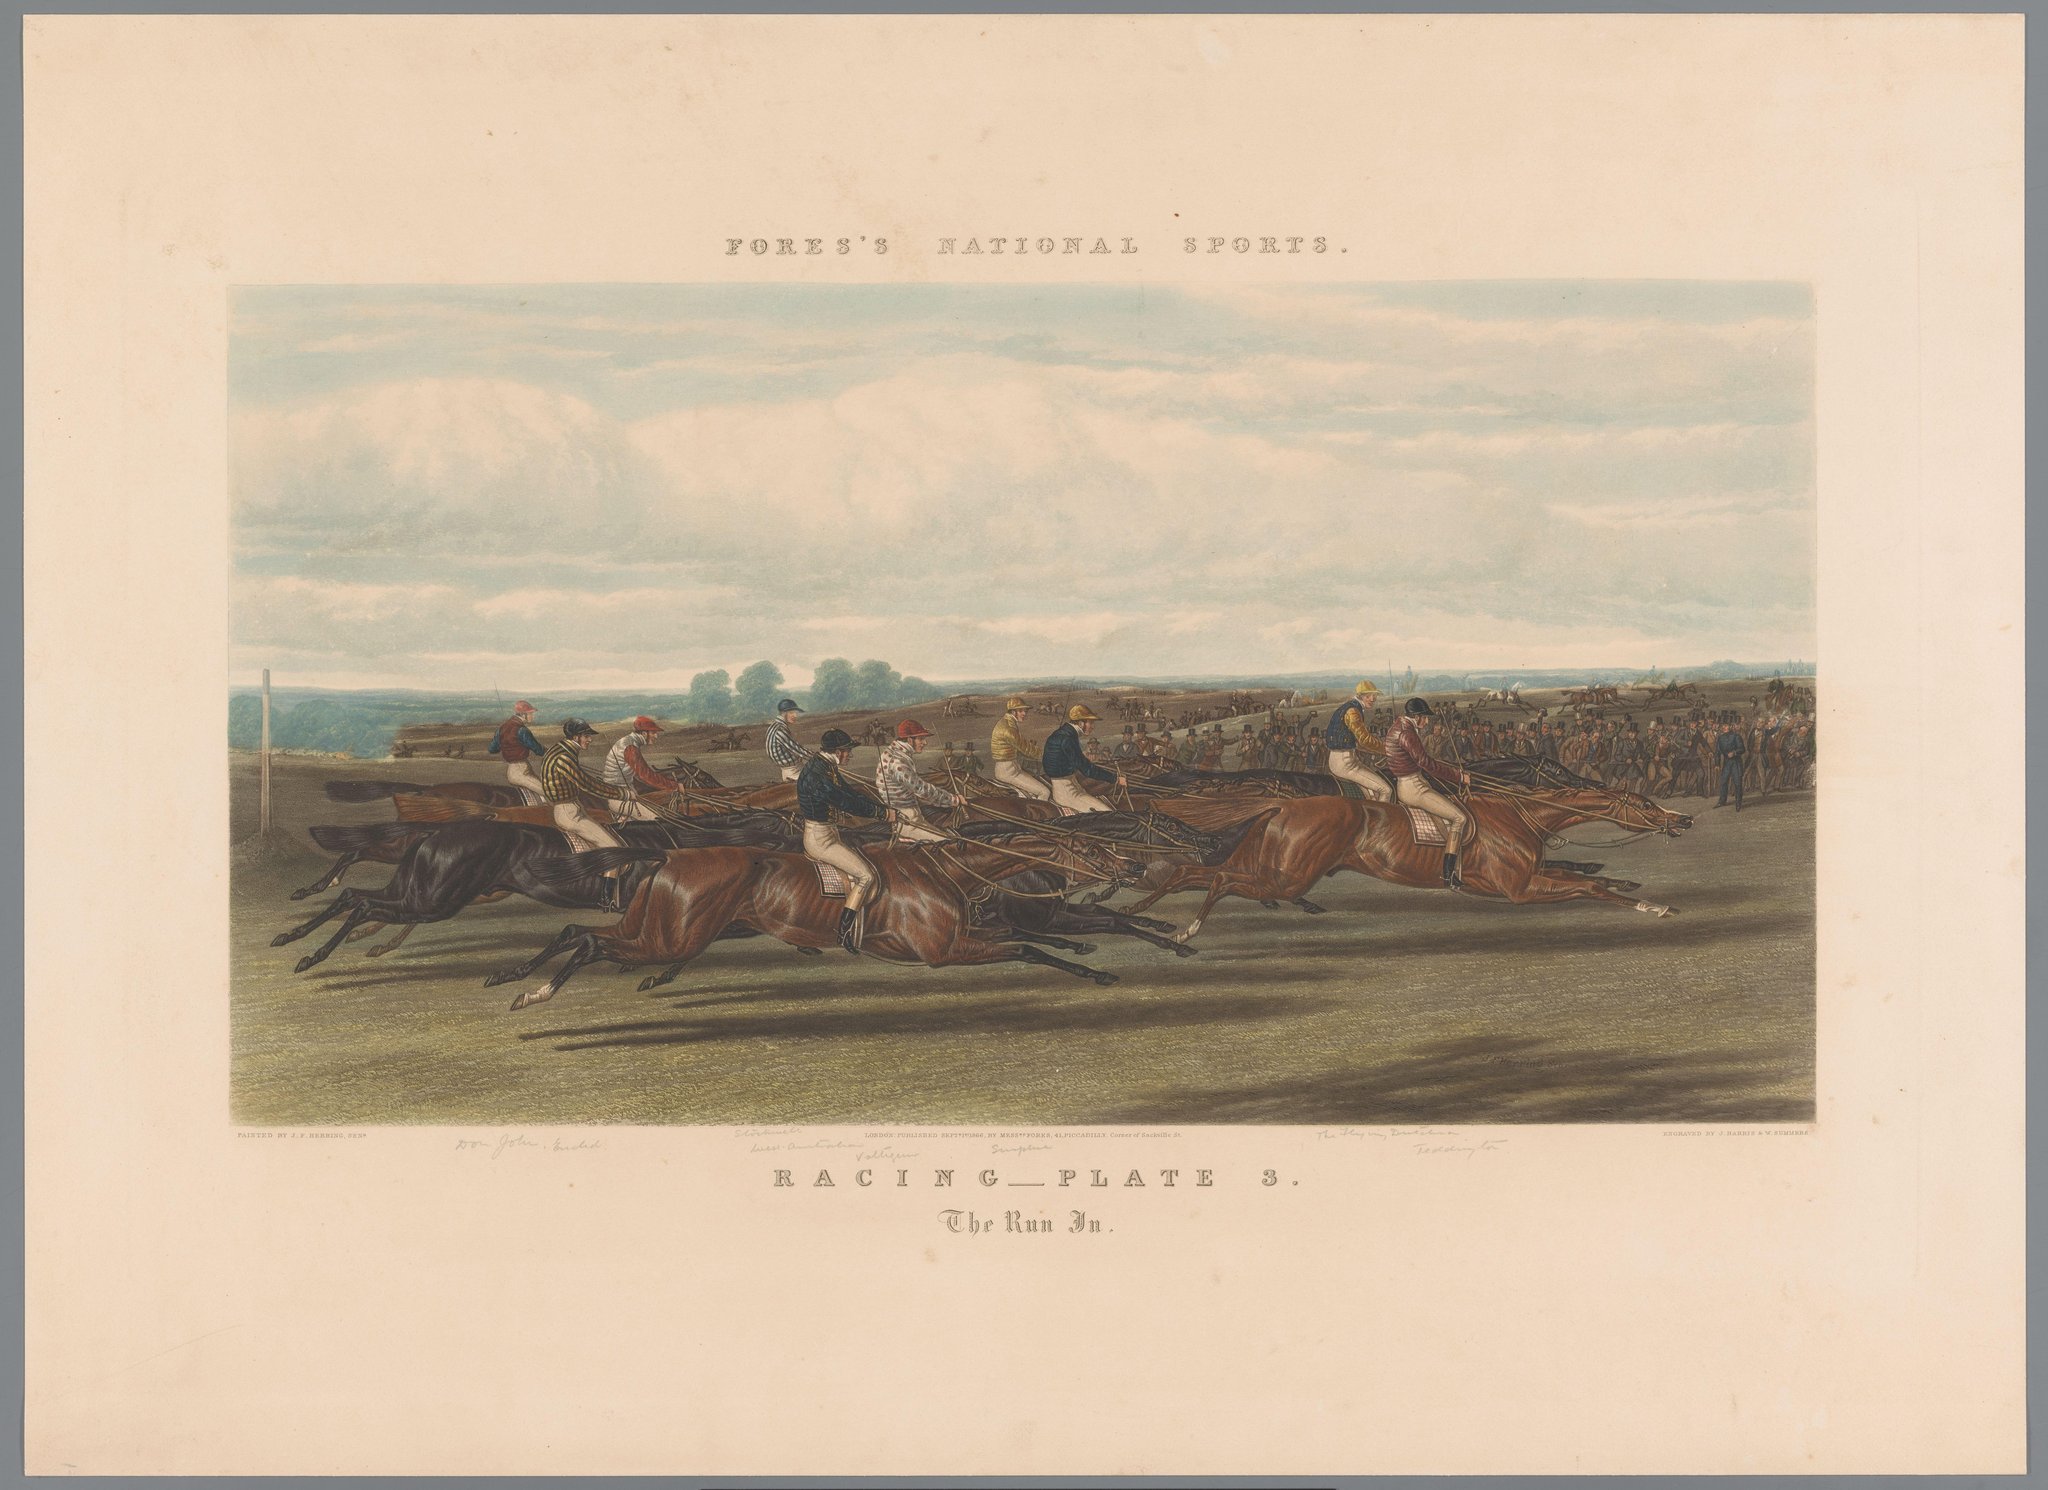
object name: print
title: Paardenrace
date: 1866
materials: paper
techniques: aquatint, etching, hand coloring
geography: london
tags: horse-racing, race-track, jockey, england